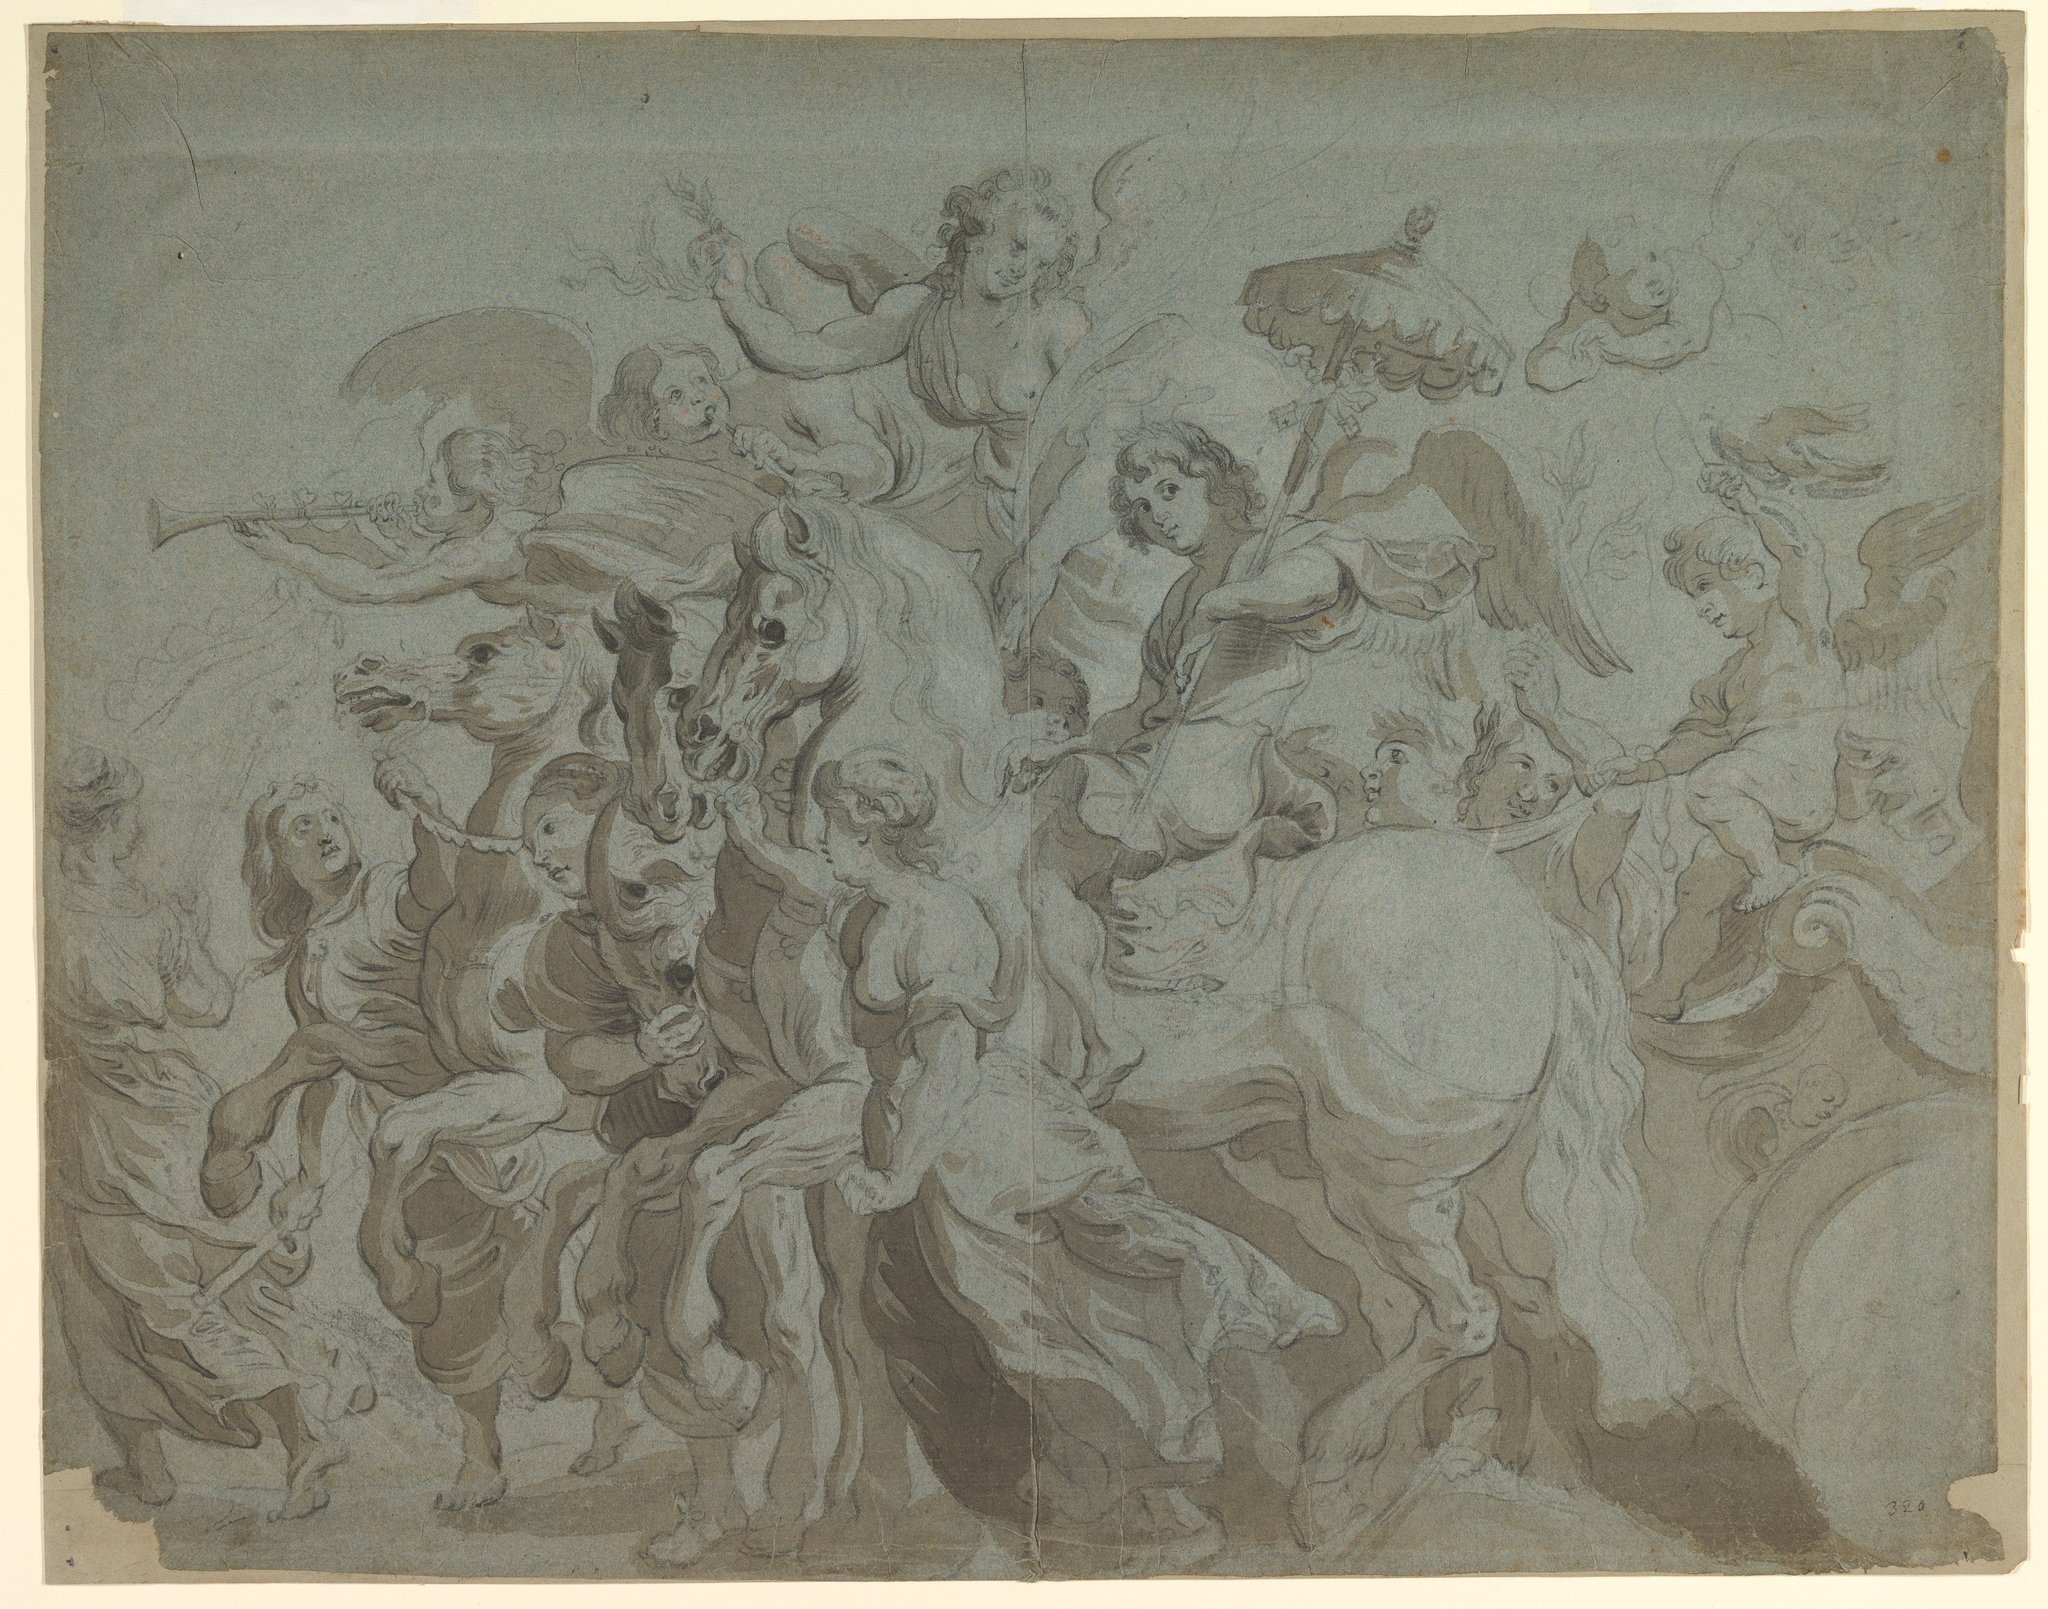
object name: drawing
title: Triumph of the Eucharist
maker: anonymous, flemish, 17th century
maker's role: artist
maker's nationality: flemish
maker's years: 1600-1700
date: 1634-1666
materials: chalk, gouache, paper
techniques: brush, heightening, wash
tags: women,horses,angels